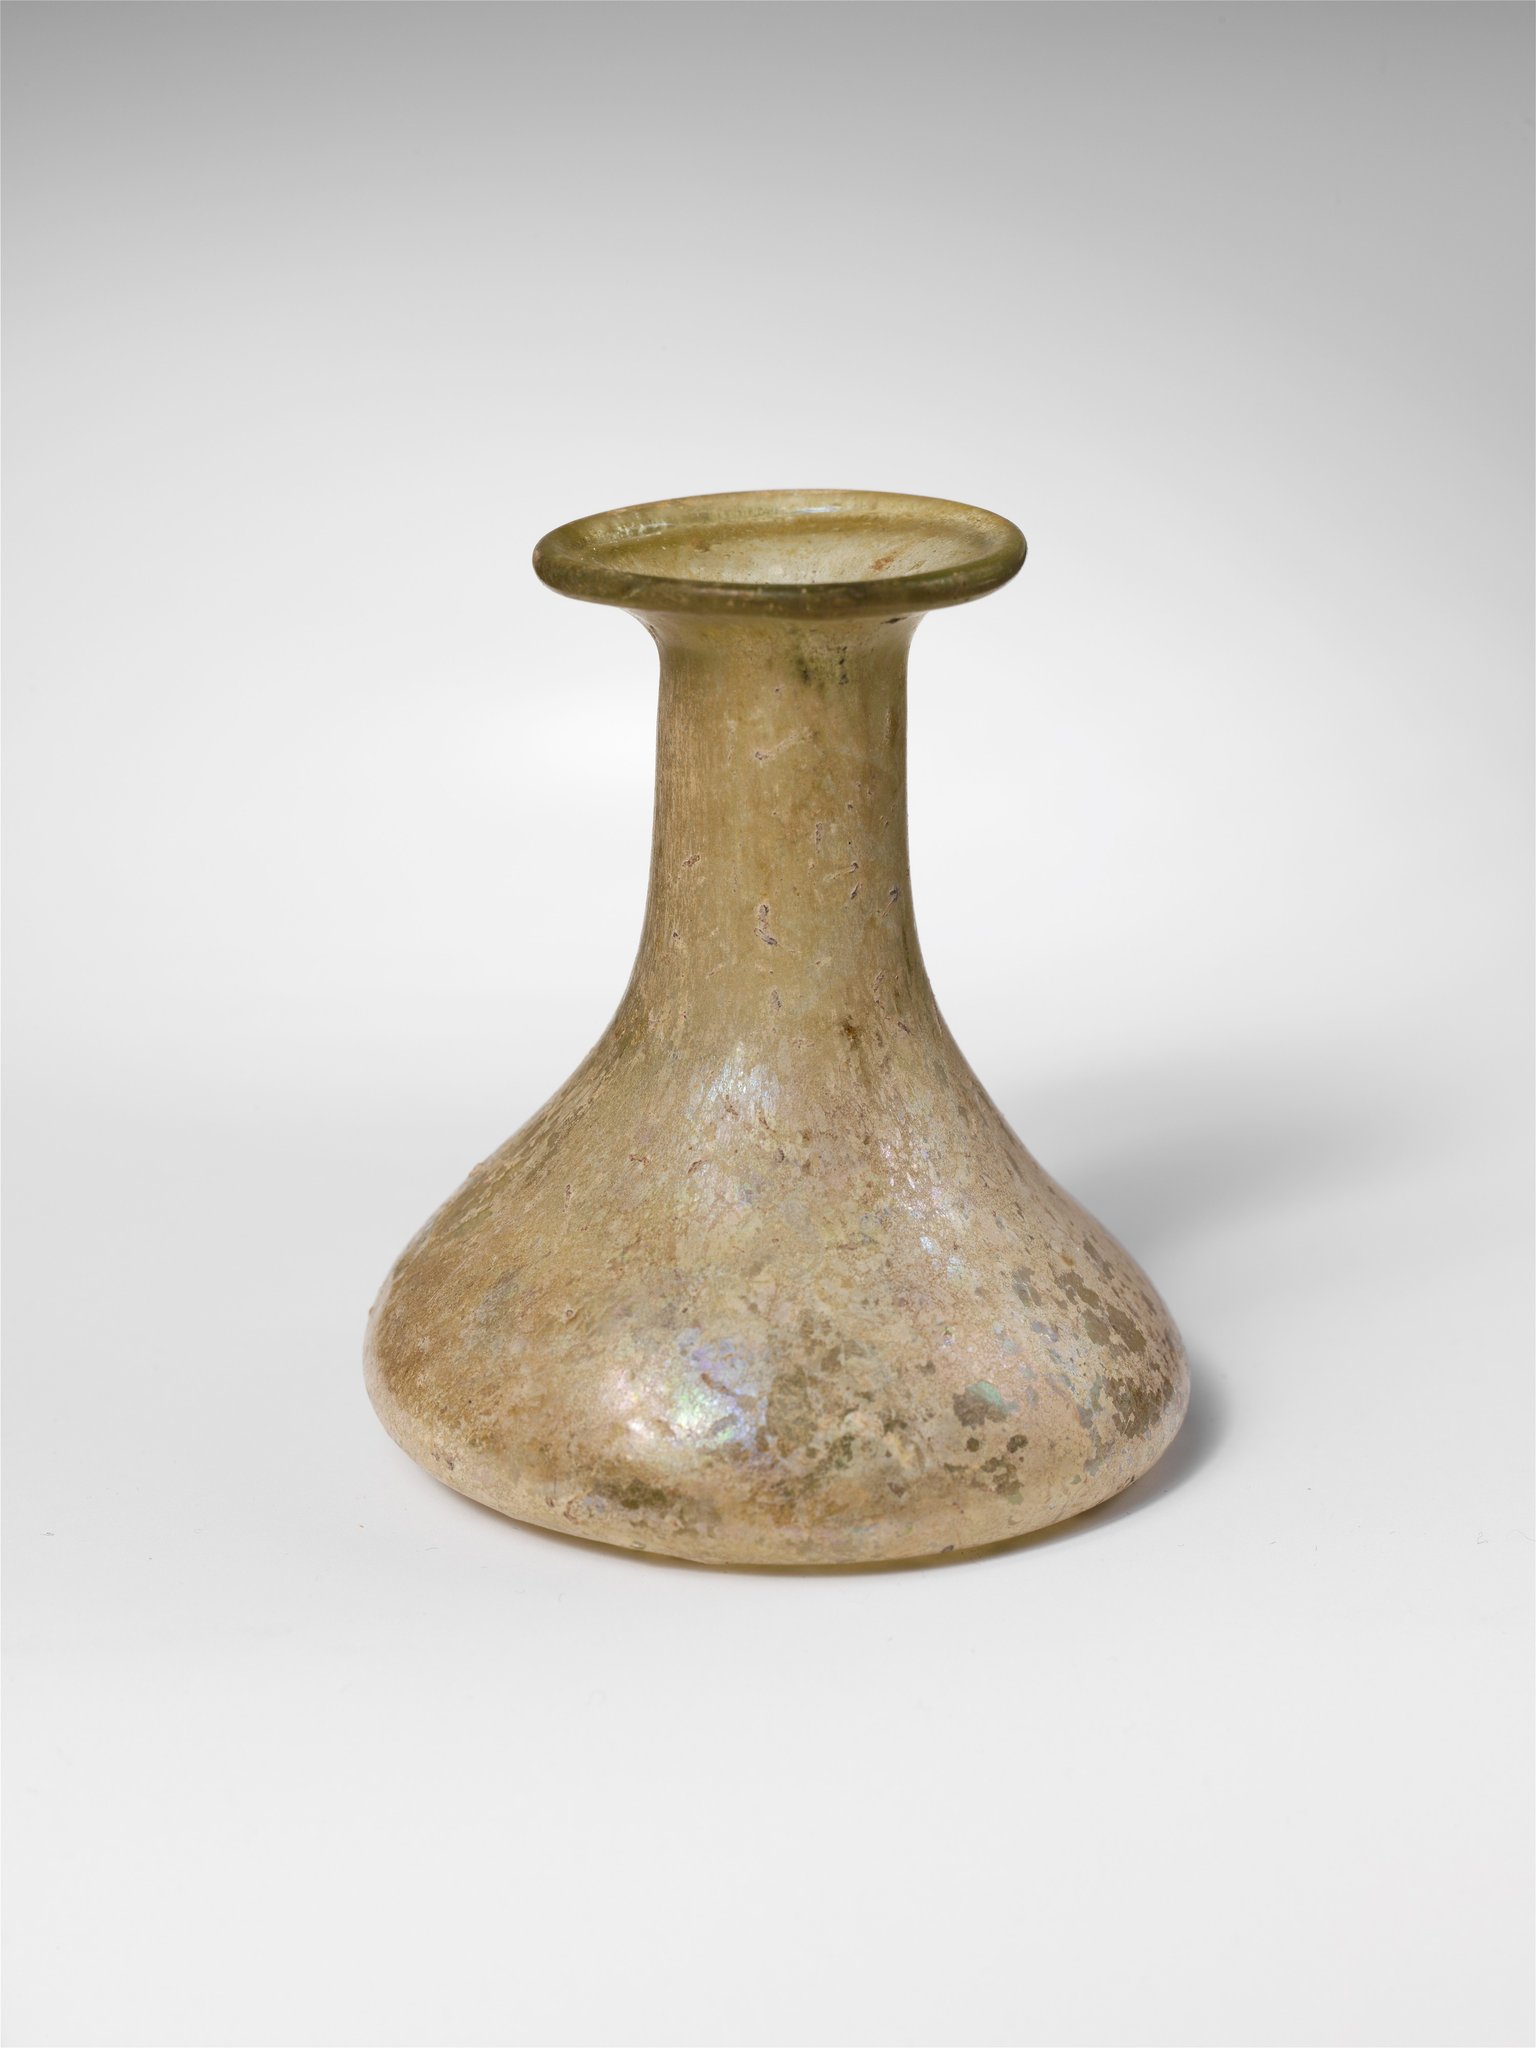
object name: bottle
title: Glass bottle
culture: roman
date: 67-300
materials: glass